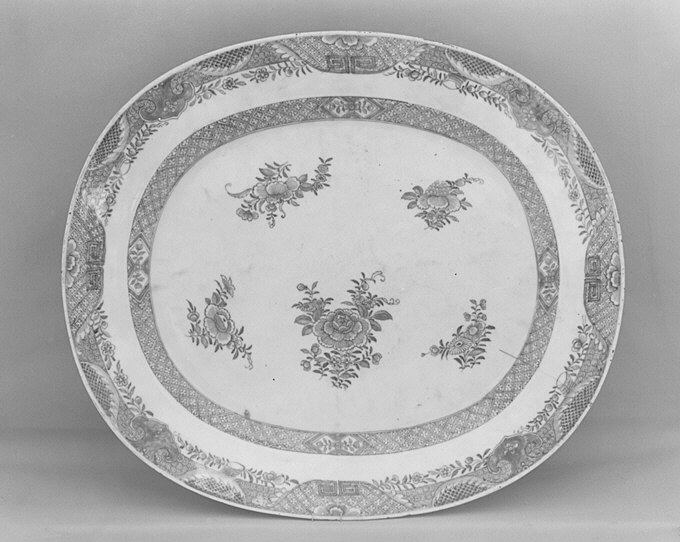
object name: dish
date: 1770-1780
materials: hard paste porcelain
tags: flowers